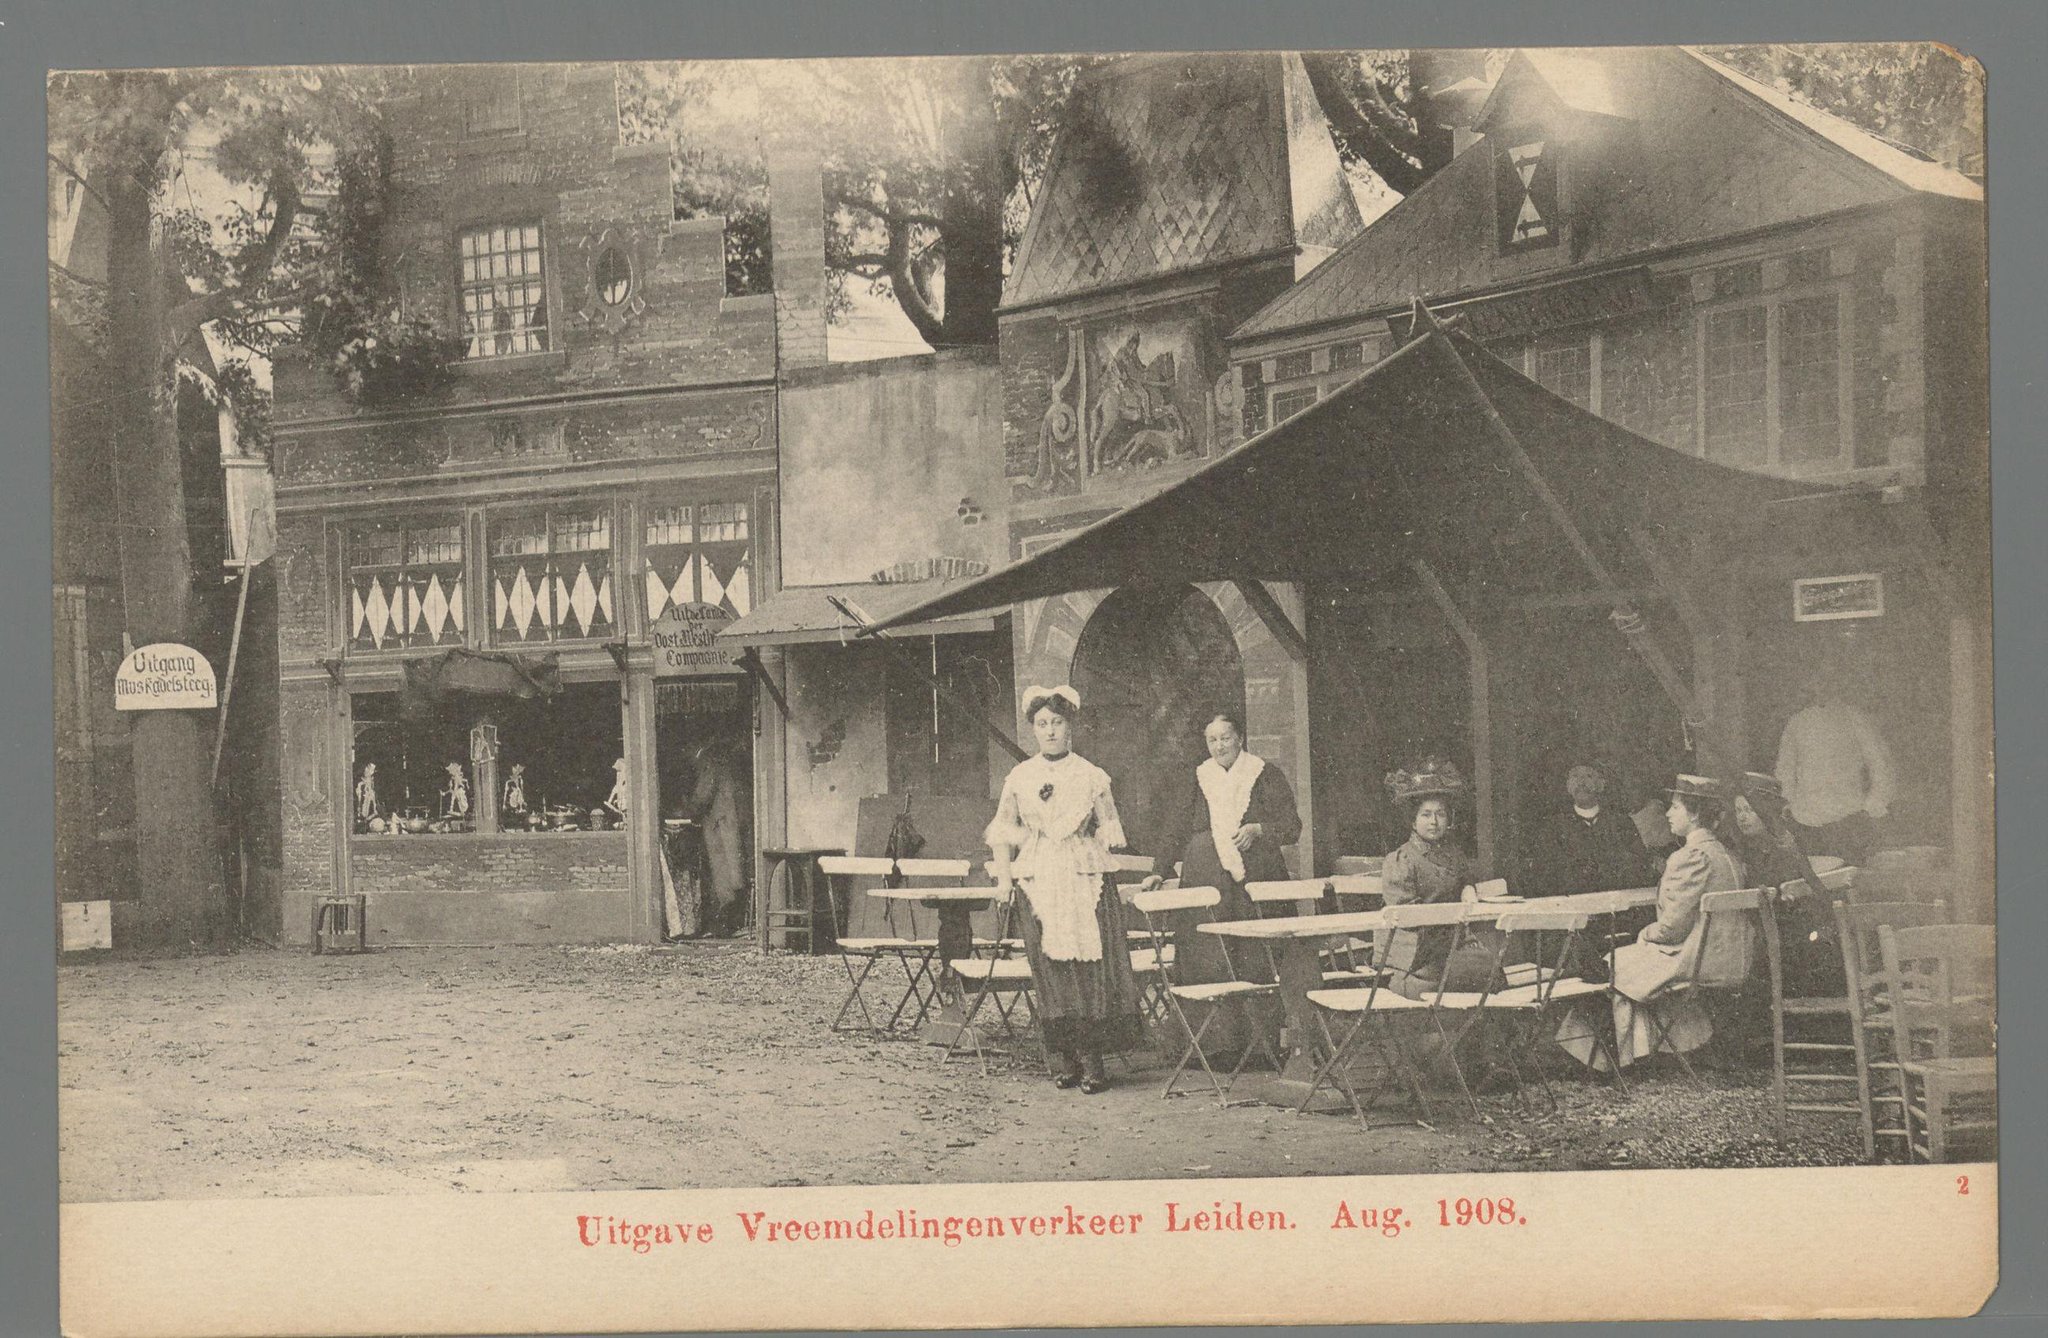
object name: ansichtkaart, prentbriefkaart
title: Mensen in kostuum voor een taverne tijdens de Oud-Hollandse feesten te Leiden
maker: Anonymous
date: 1908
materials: cardboard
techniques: photograph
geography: leiden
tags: dress-up party, inn, coffee-house, public house, etc., festivities, leiden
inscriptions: date